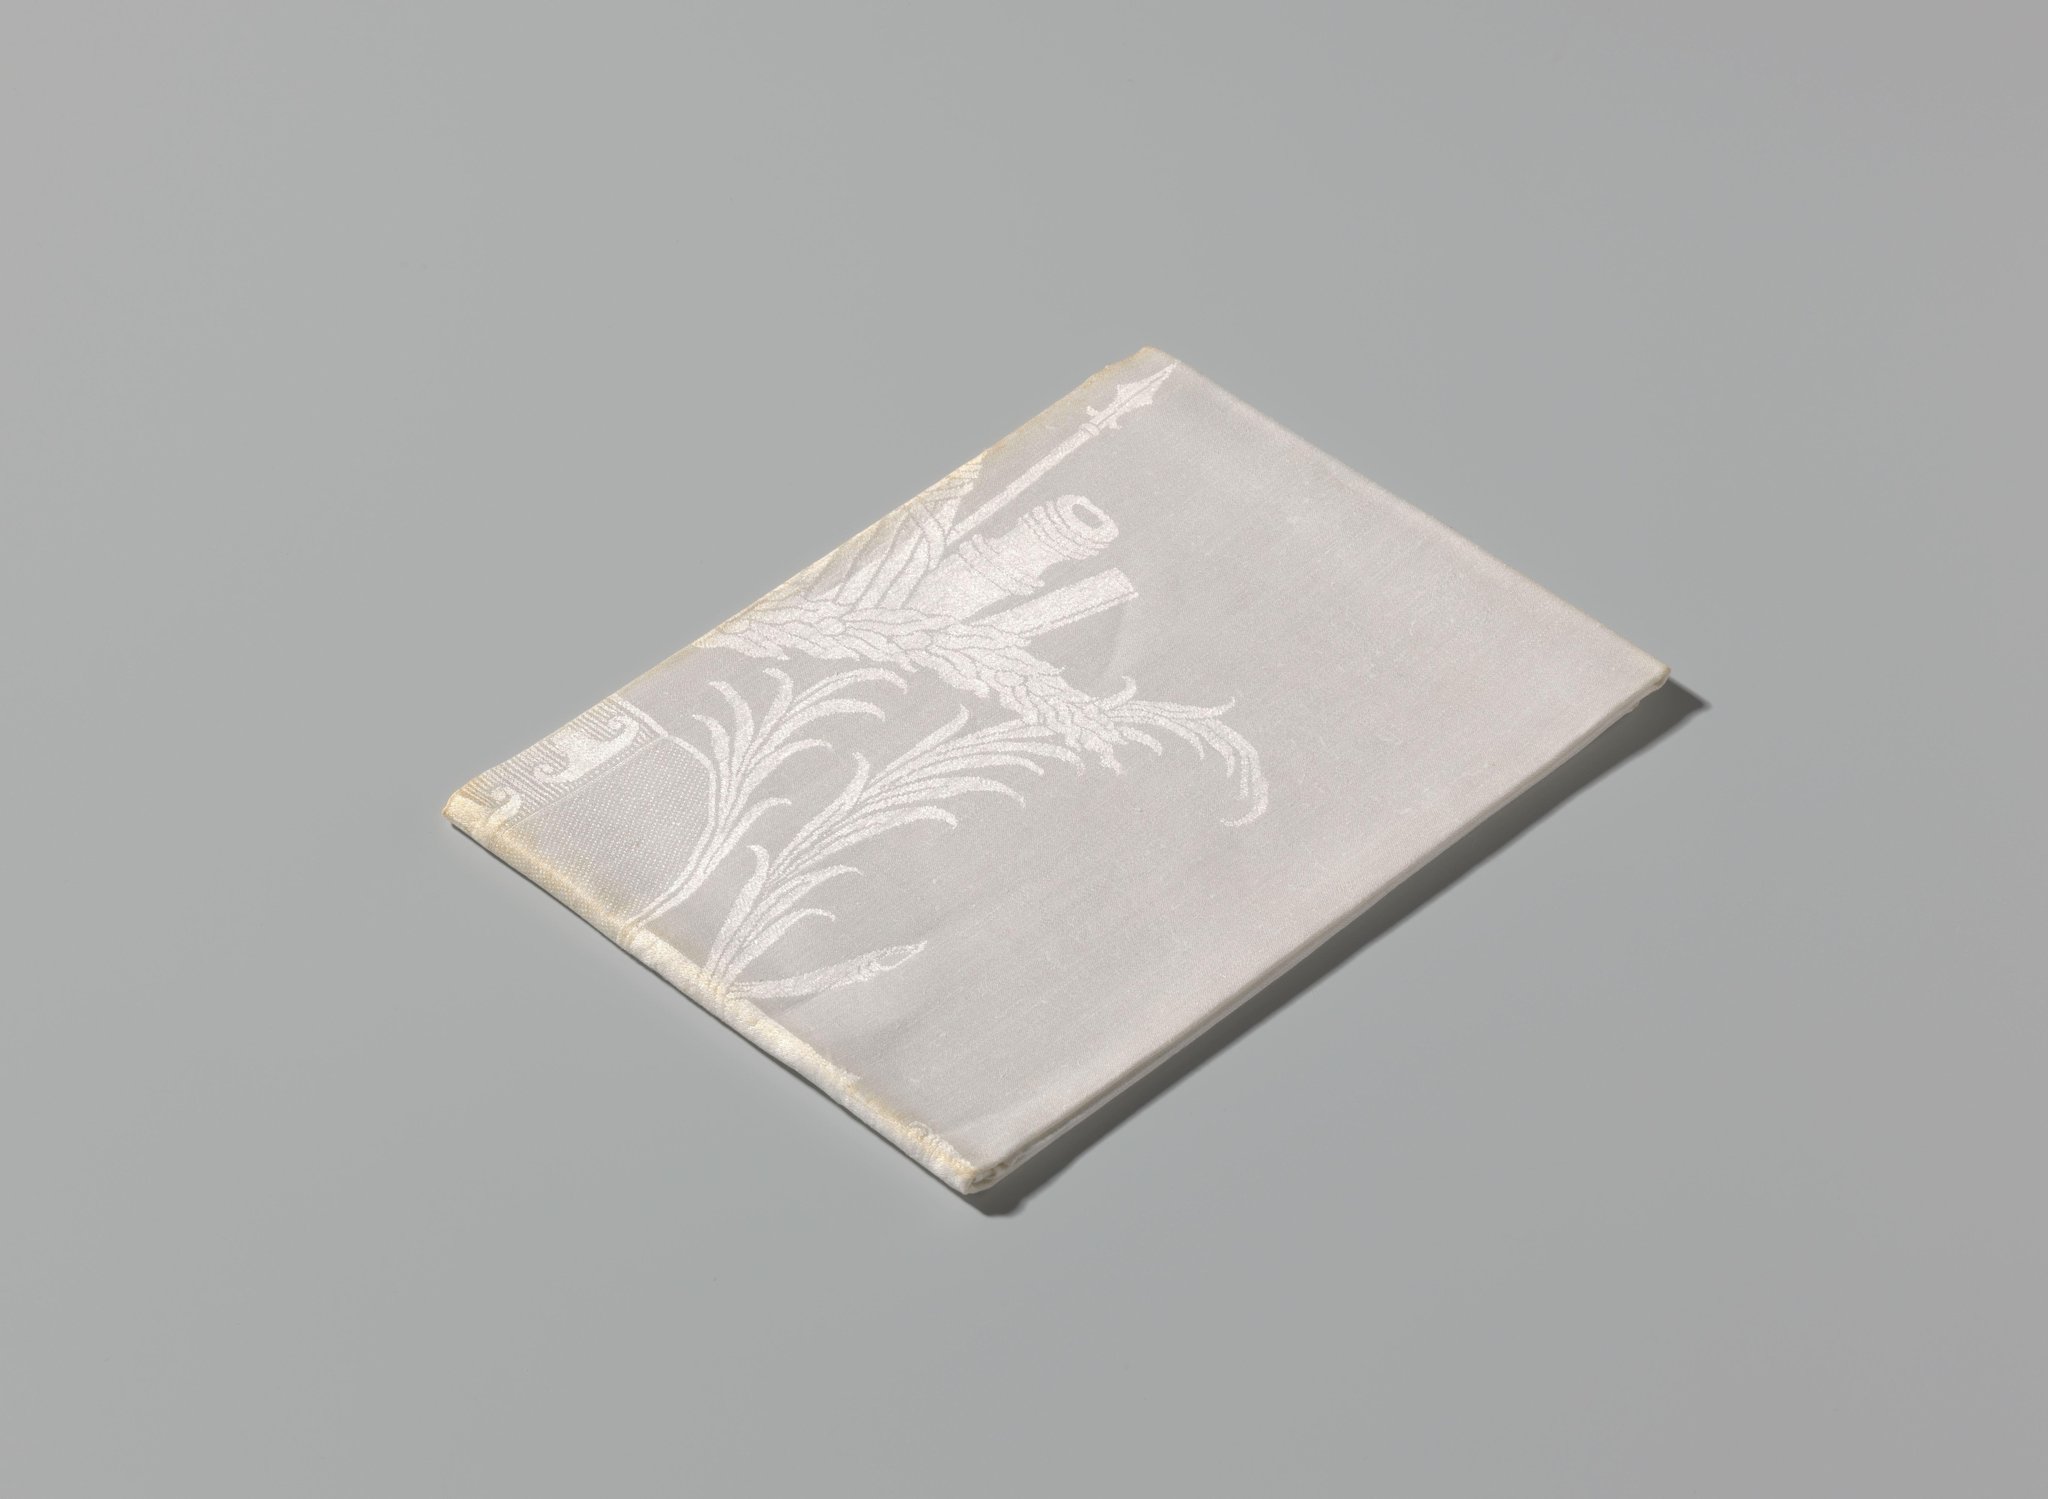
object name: napkin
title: Servet met het wapen van Wijk bij Duurstede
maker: Anonymous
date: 1786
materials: linen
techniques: damask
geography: north brabant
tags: wijk bij duurstede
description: Servet van linnendamast met het wapen van Wijk bij Duurstede. Middenveld: In de breedte geplaatst voor een speer met vrijheidshoed, het wapen van Wijk bij Duurstede: goud met balk van keel, beladen met drie zuilen; het is omgeven door twee lauwertakken en rust op een trofee van bajonetten, vlaggen, vuurmond en fascesbundel. Daaronder: 20 MAART Ao 1786 en daarboven DAN 36. Randen: slingerende tak met eikebladeren en eikels, een effen bandlijst en een blokkenrand.